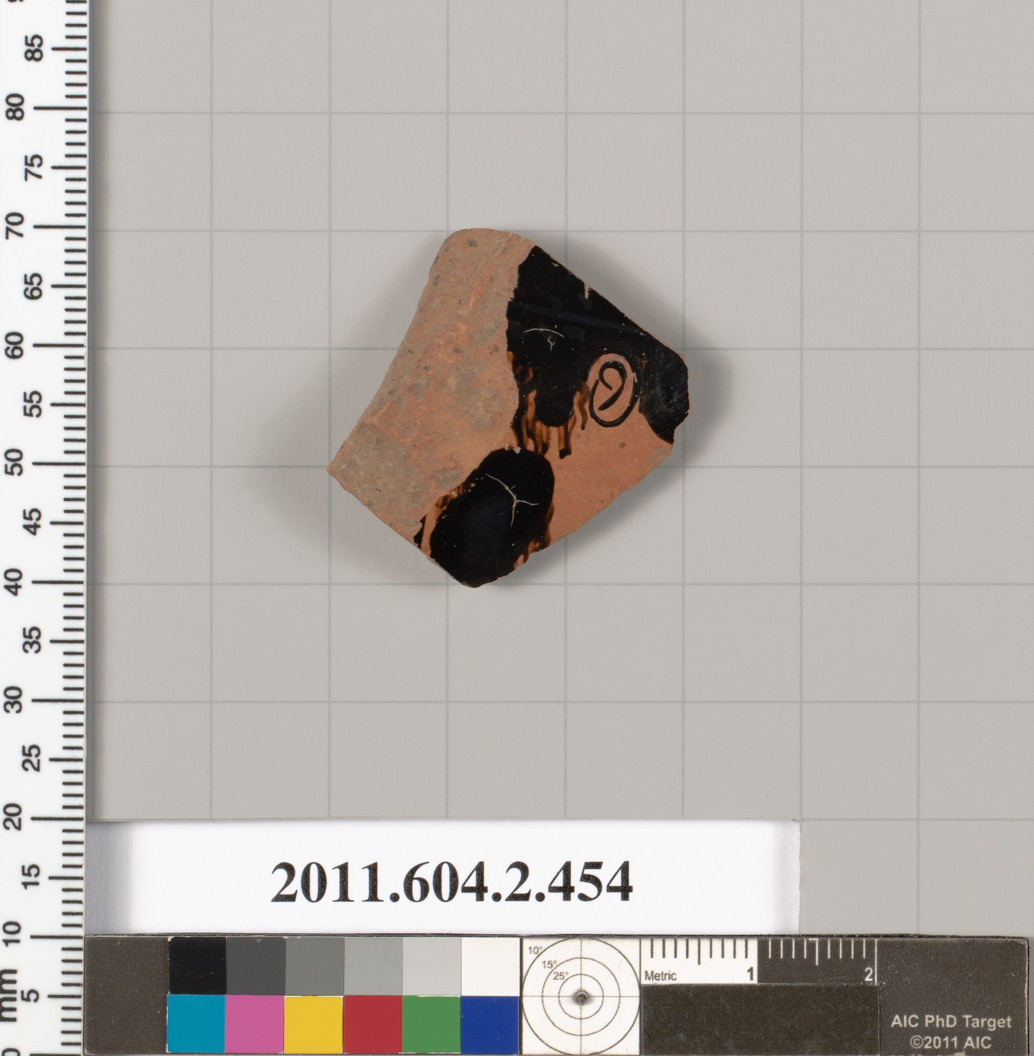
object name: column krater fragment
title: Terracotta fragment of a column-krater (bowl for mixing wine and water)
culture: greek, attic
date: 480-470 BCE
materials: terracotta